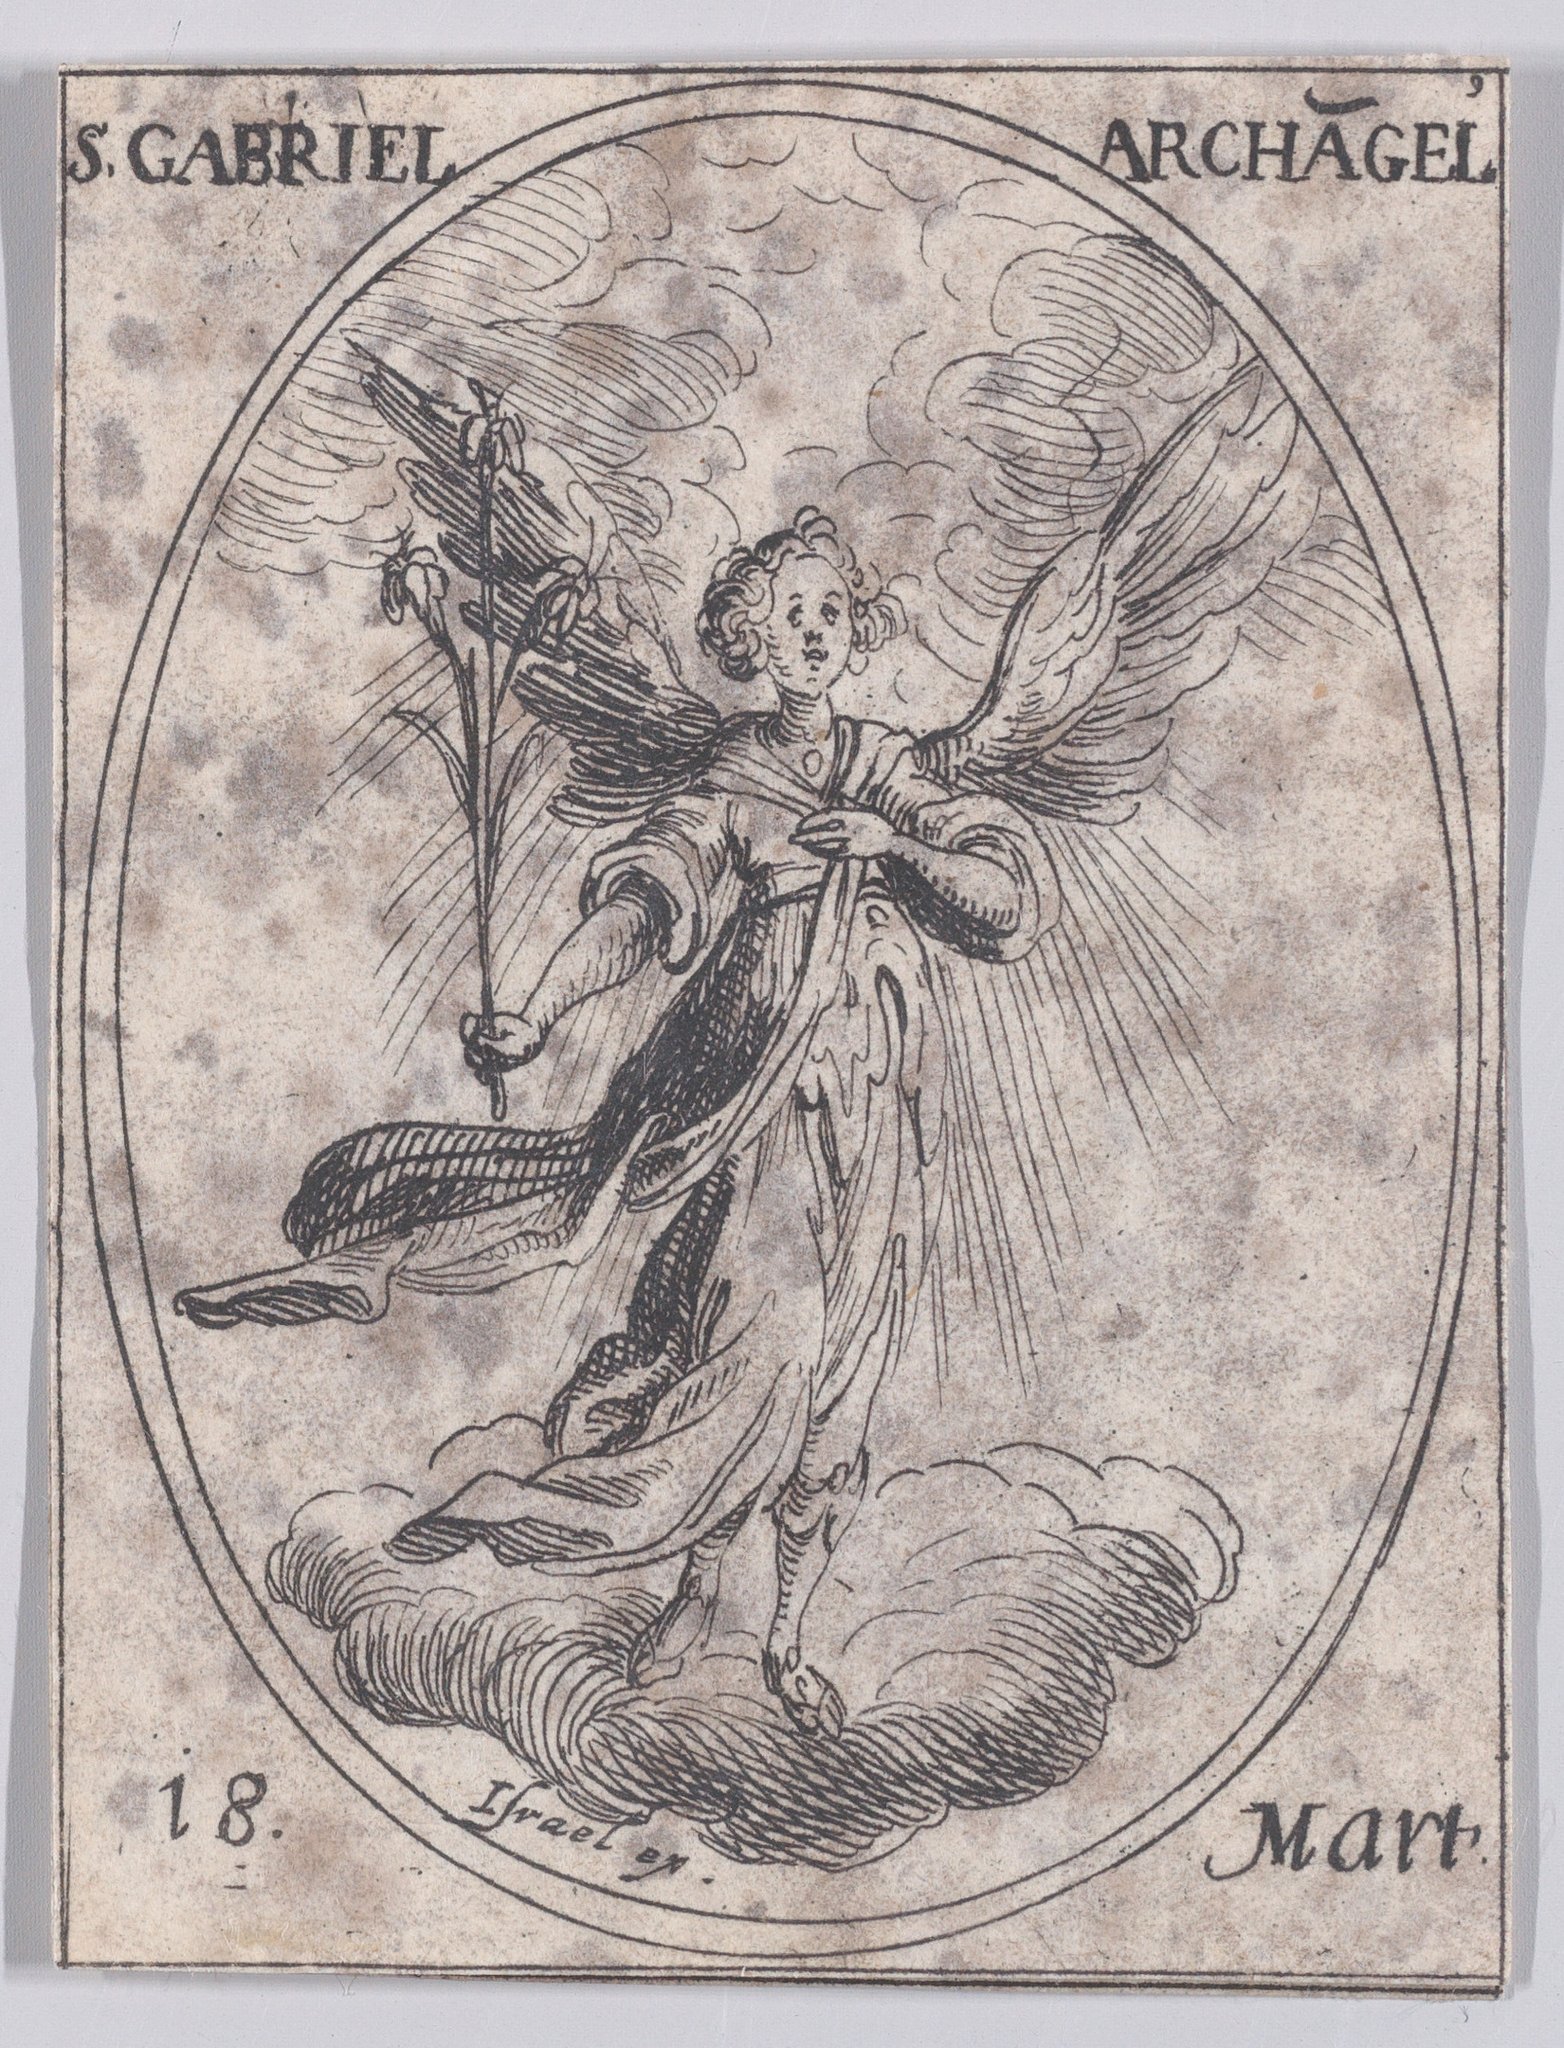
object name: print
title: S. Gabriel, archange (St. Gabriel, Archangel), March 18th, from "Les Images De Tous Les Saincts et Saintes de L'Année" (Images of All of the Saints and Religious Events of the Year)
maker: jacques callot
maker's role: artist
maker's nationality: french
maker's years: 1592-1635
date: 1636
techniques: etching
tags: archangel gabriel